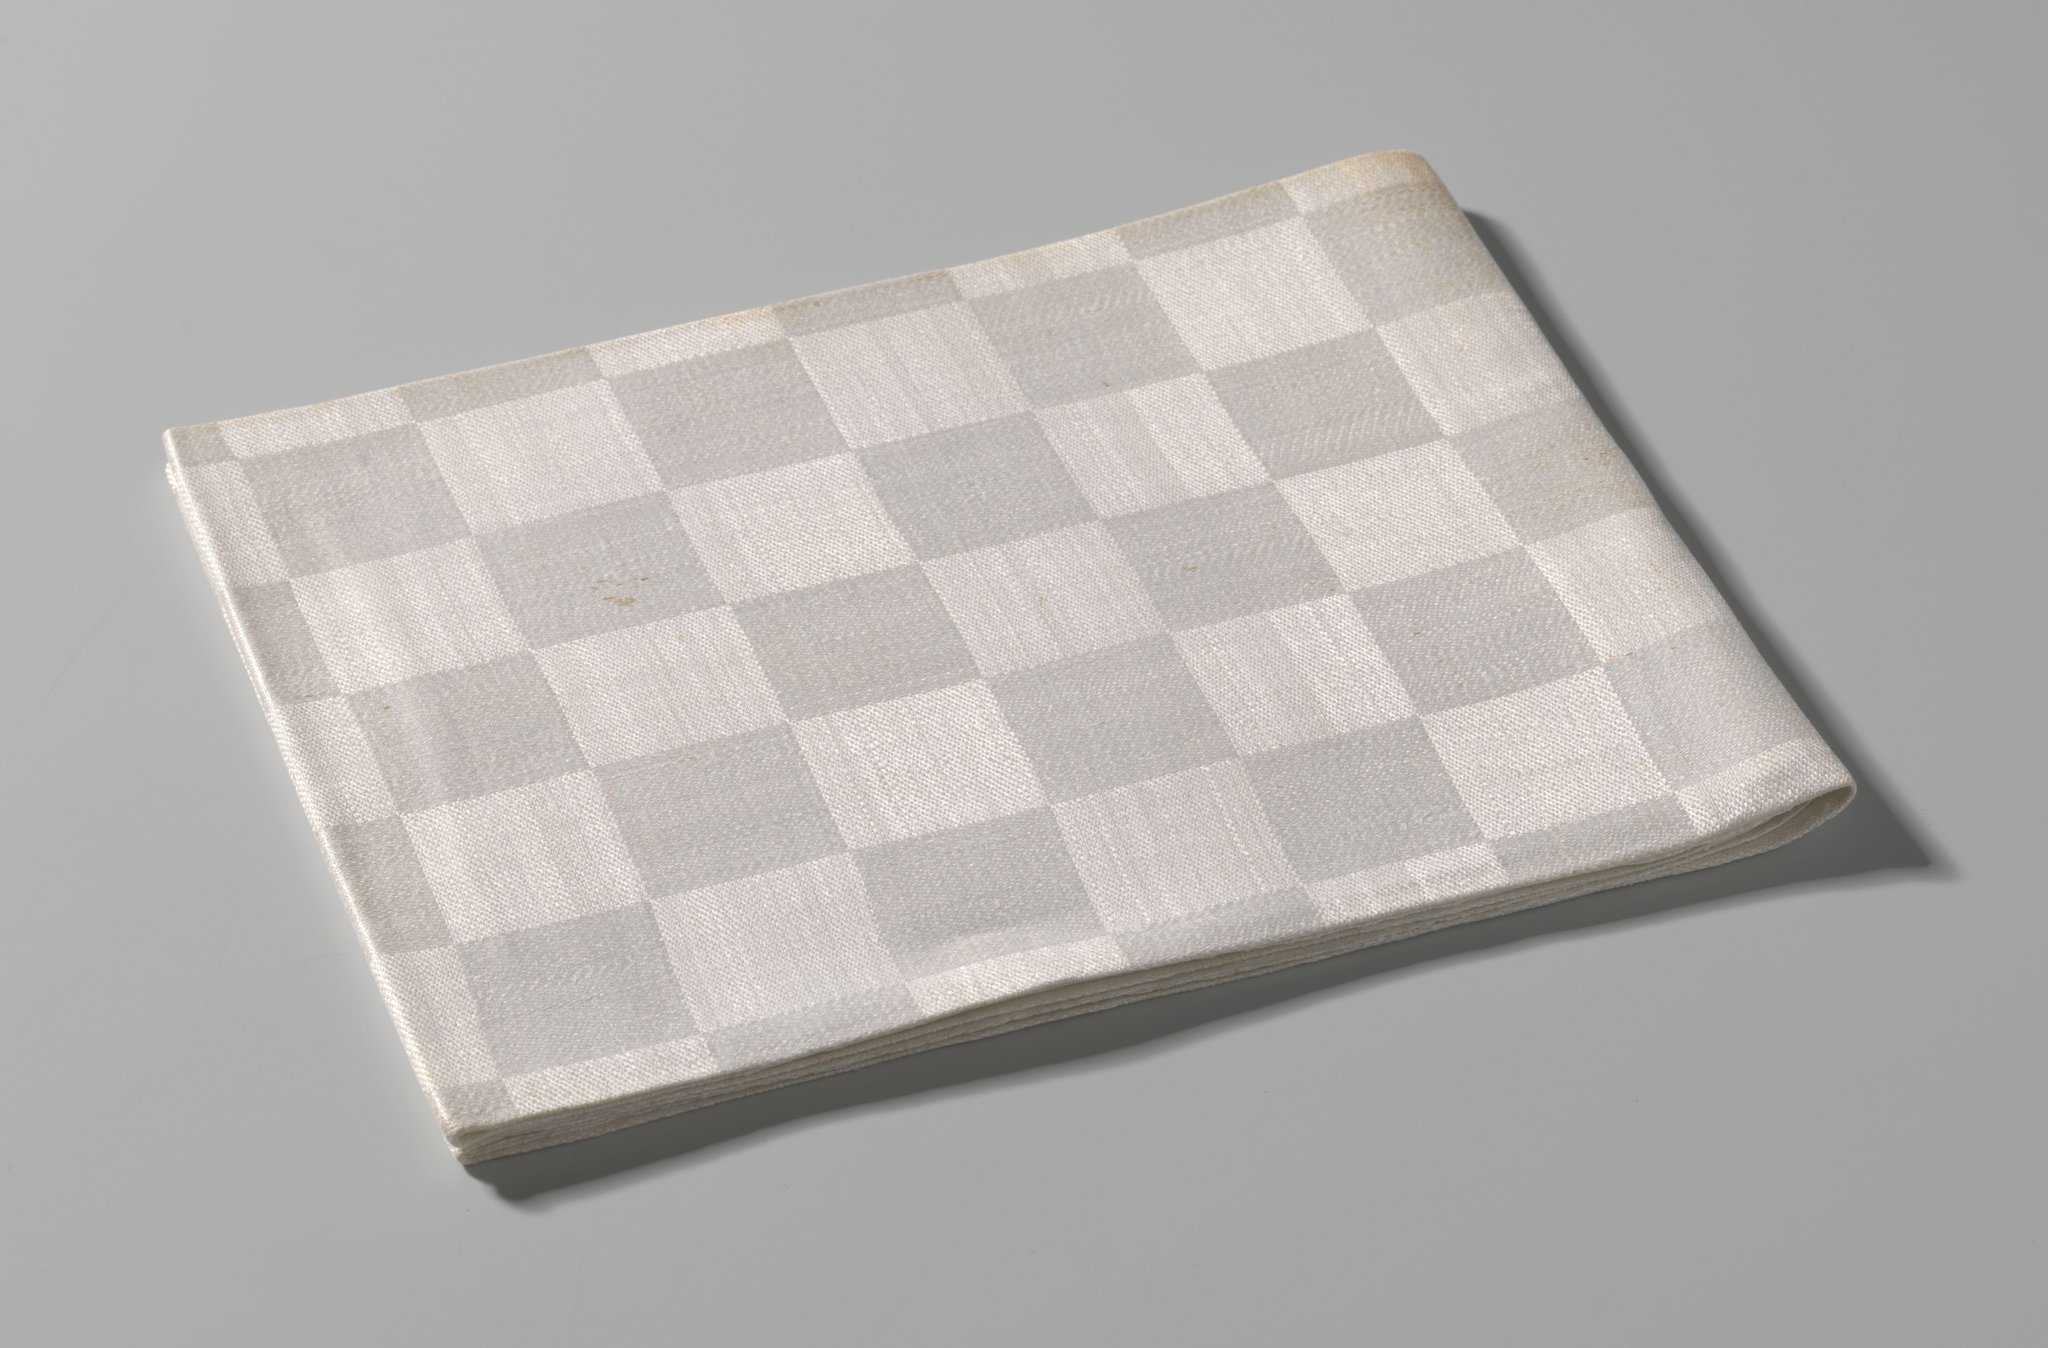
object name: napkin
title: Servet van linnen met pellenpatroon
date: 1830-1870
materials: linen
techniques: peeled fabric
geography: northern netherlands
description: Wit linnen servet met pellenpatroon, merk HW 80.